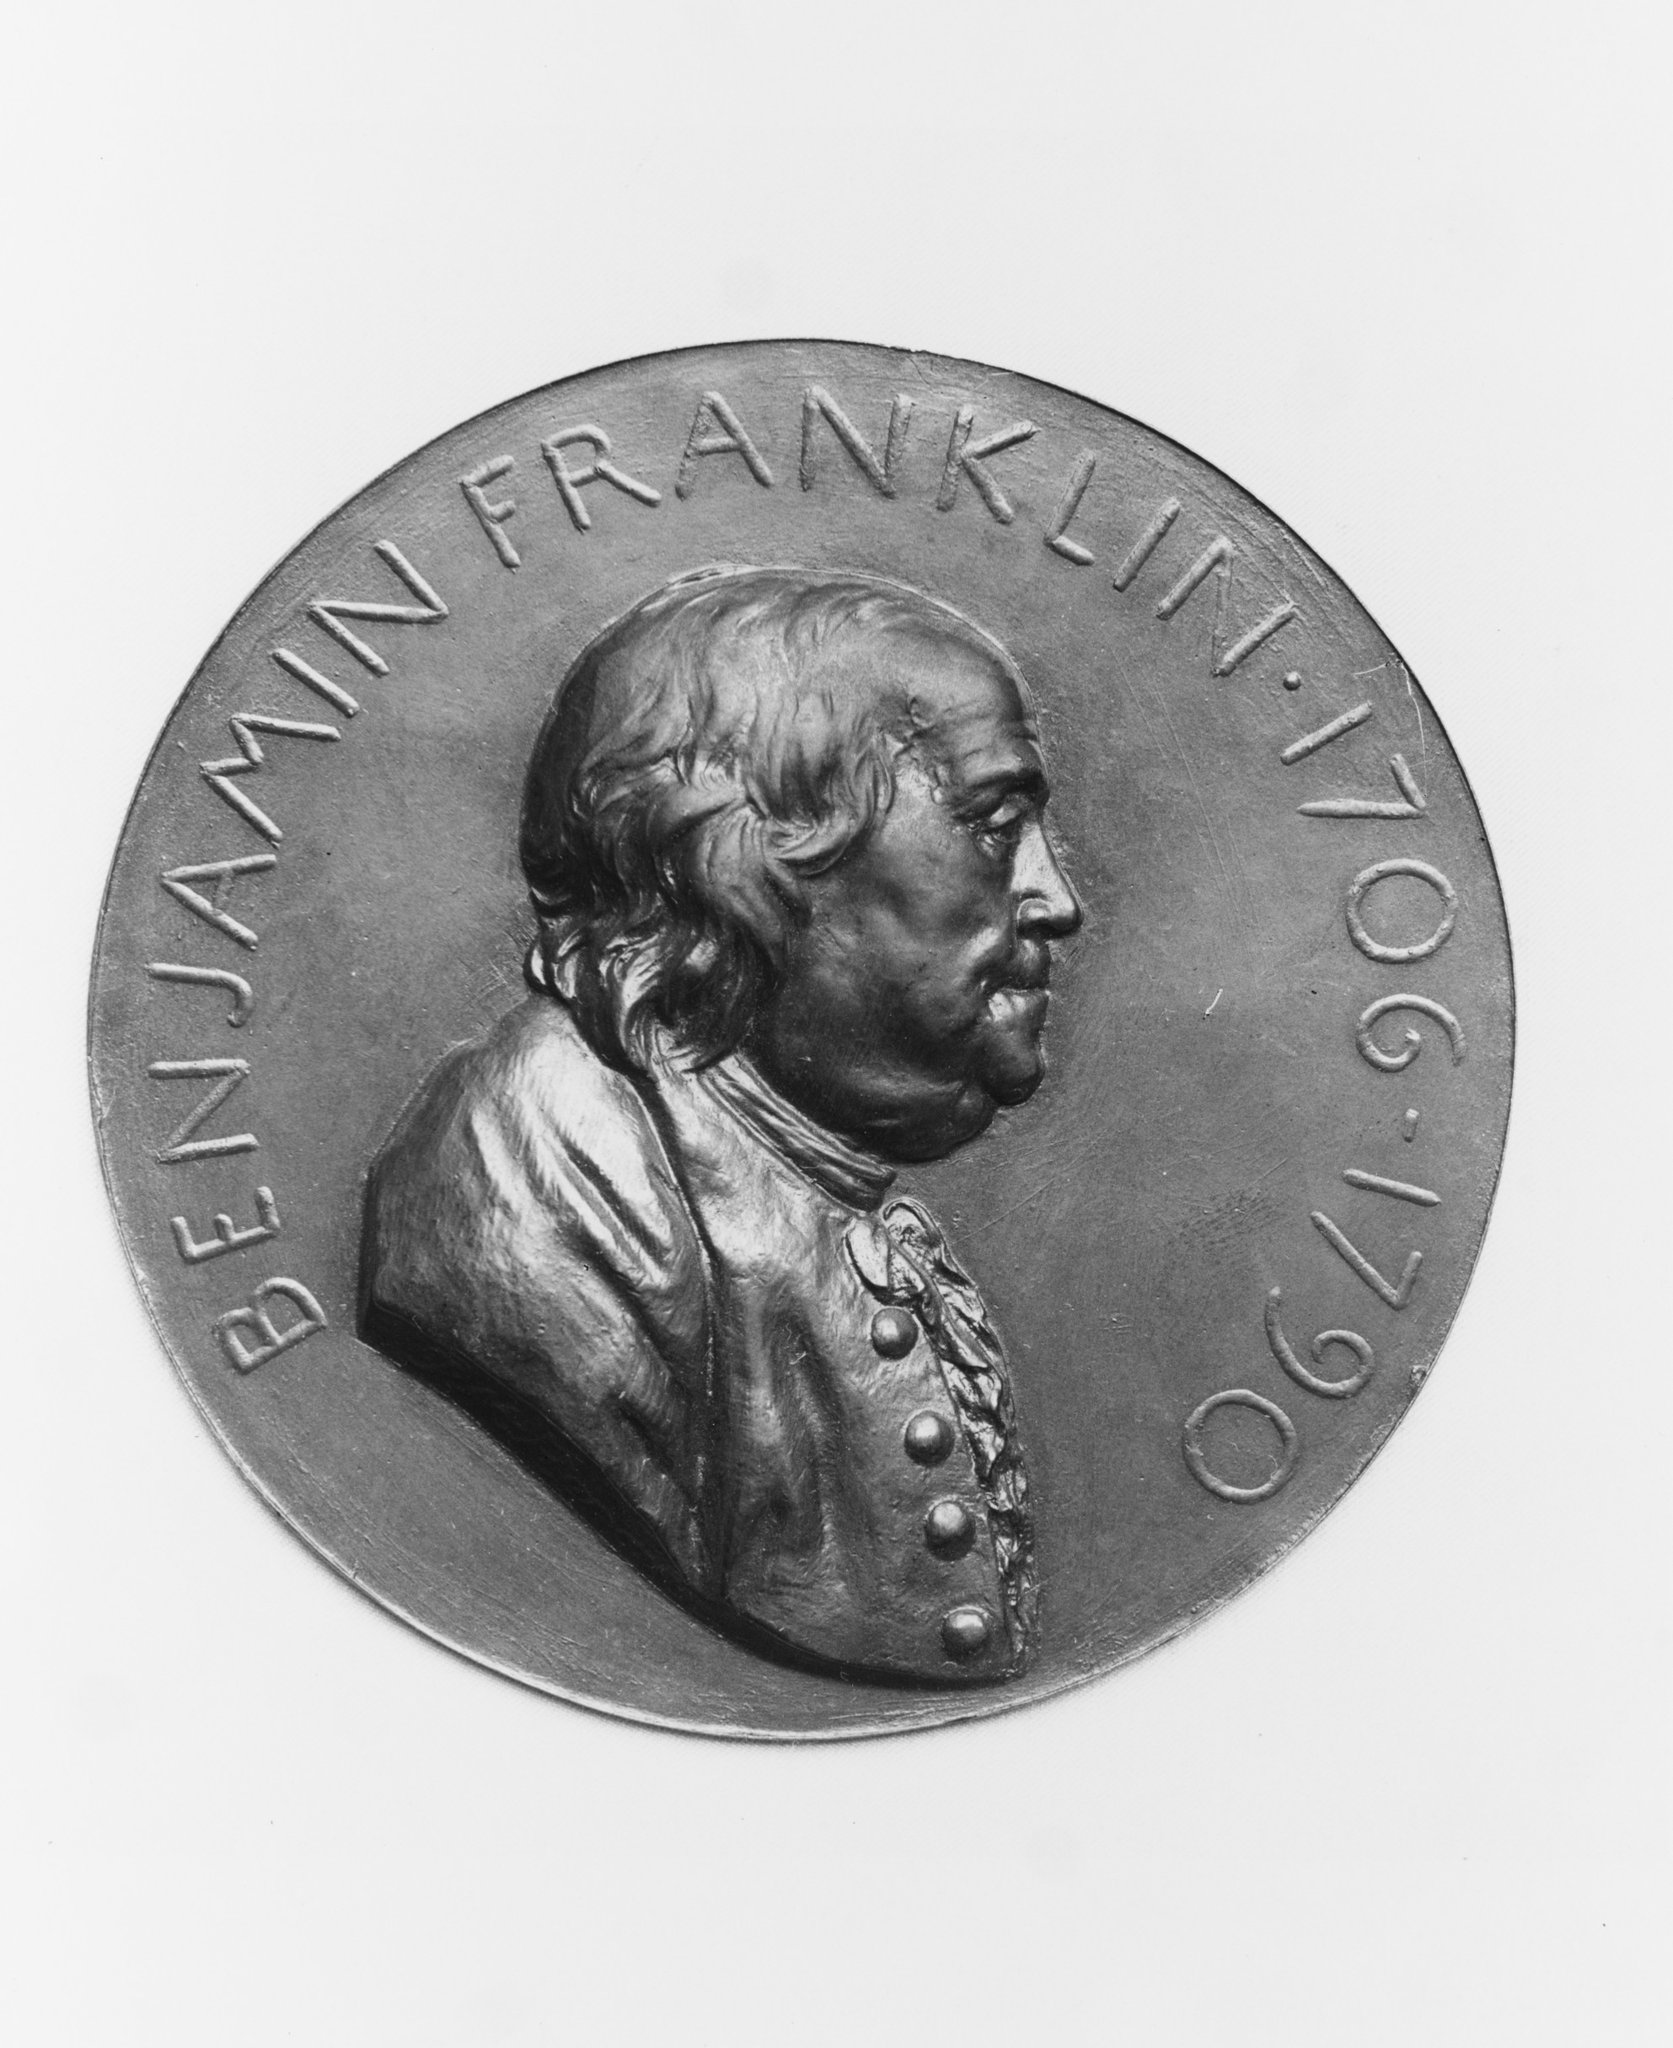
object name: medallion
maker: jean martin renaud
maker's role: maker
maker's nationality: french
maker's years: 1746-1821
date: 1870-1900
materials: copper, patina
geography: france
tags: benjamin franklin,men,profiles